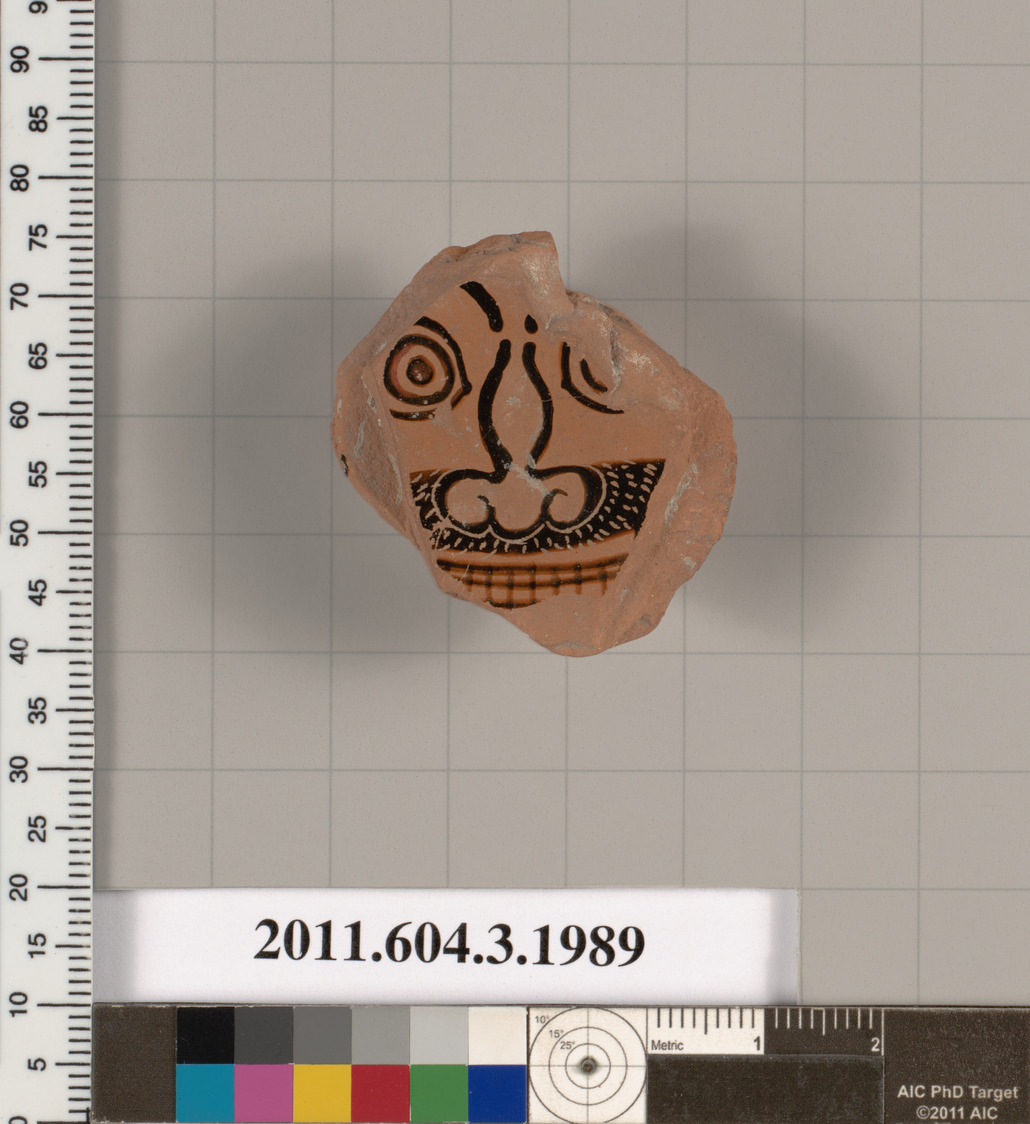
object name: kylix fragment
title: Terracotta fragment of a kylix (drinking cup)?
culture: greek, attic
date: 560-550 BCE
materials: terracotta